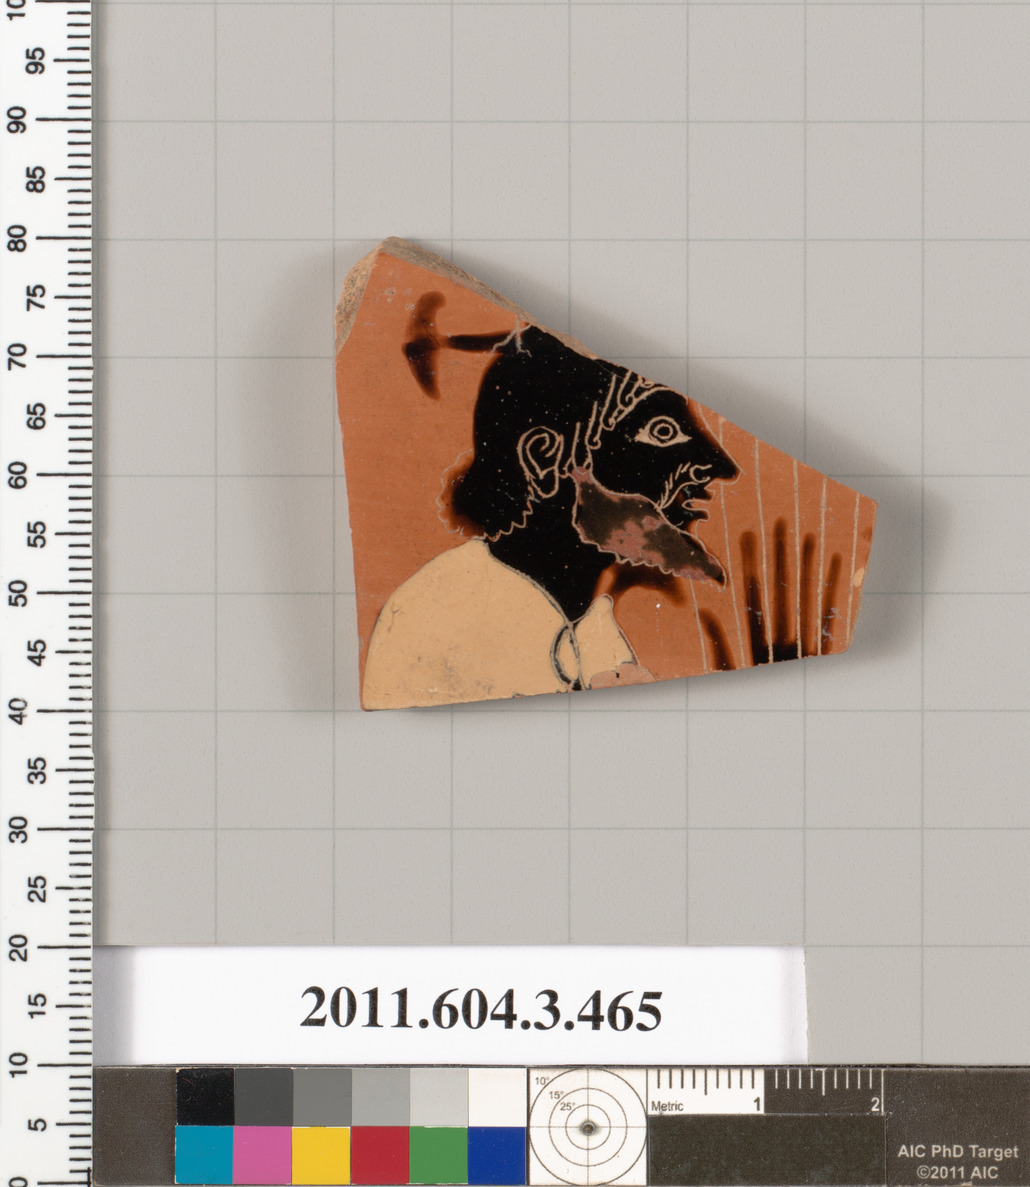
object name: amphora fragment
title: Terracotta fragment of an amphora (jar)?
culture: greek, attic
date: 550-526 BCE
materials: terracotta